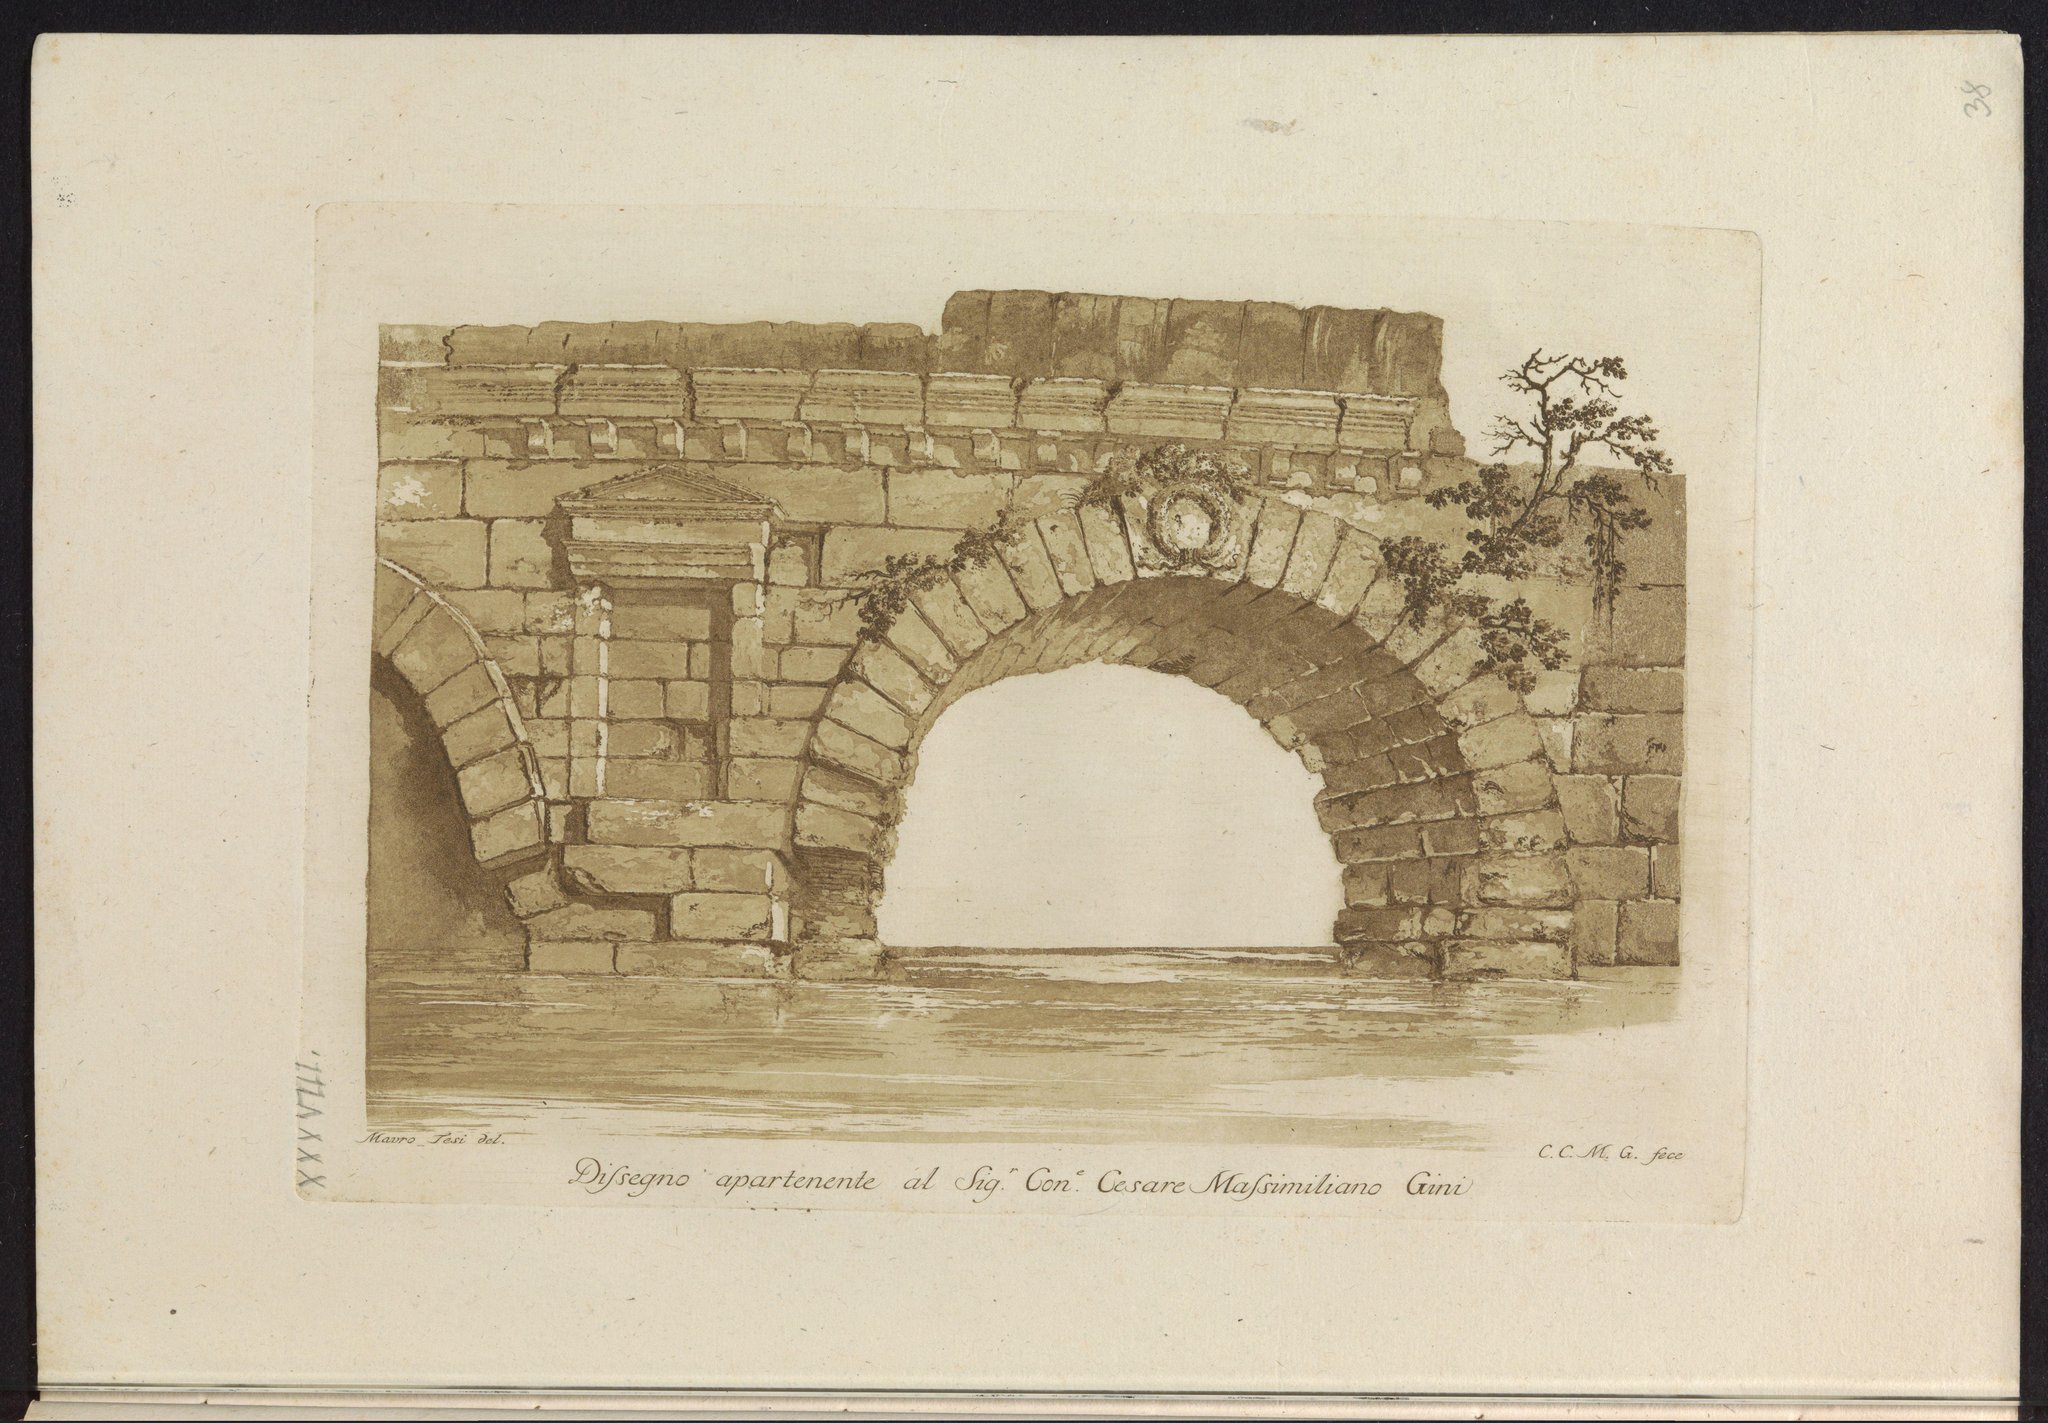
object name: album leaf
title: Raccolta di dissegni originali di Mauro Tesi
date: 1787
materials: paper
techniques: aquatint, etching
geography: bologna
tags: bridge